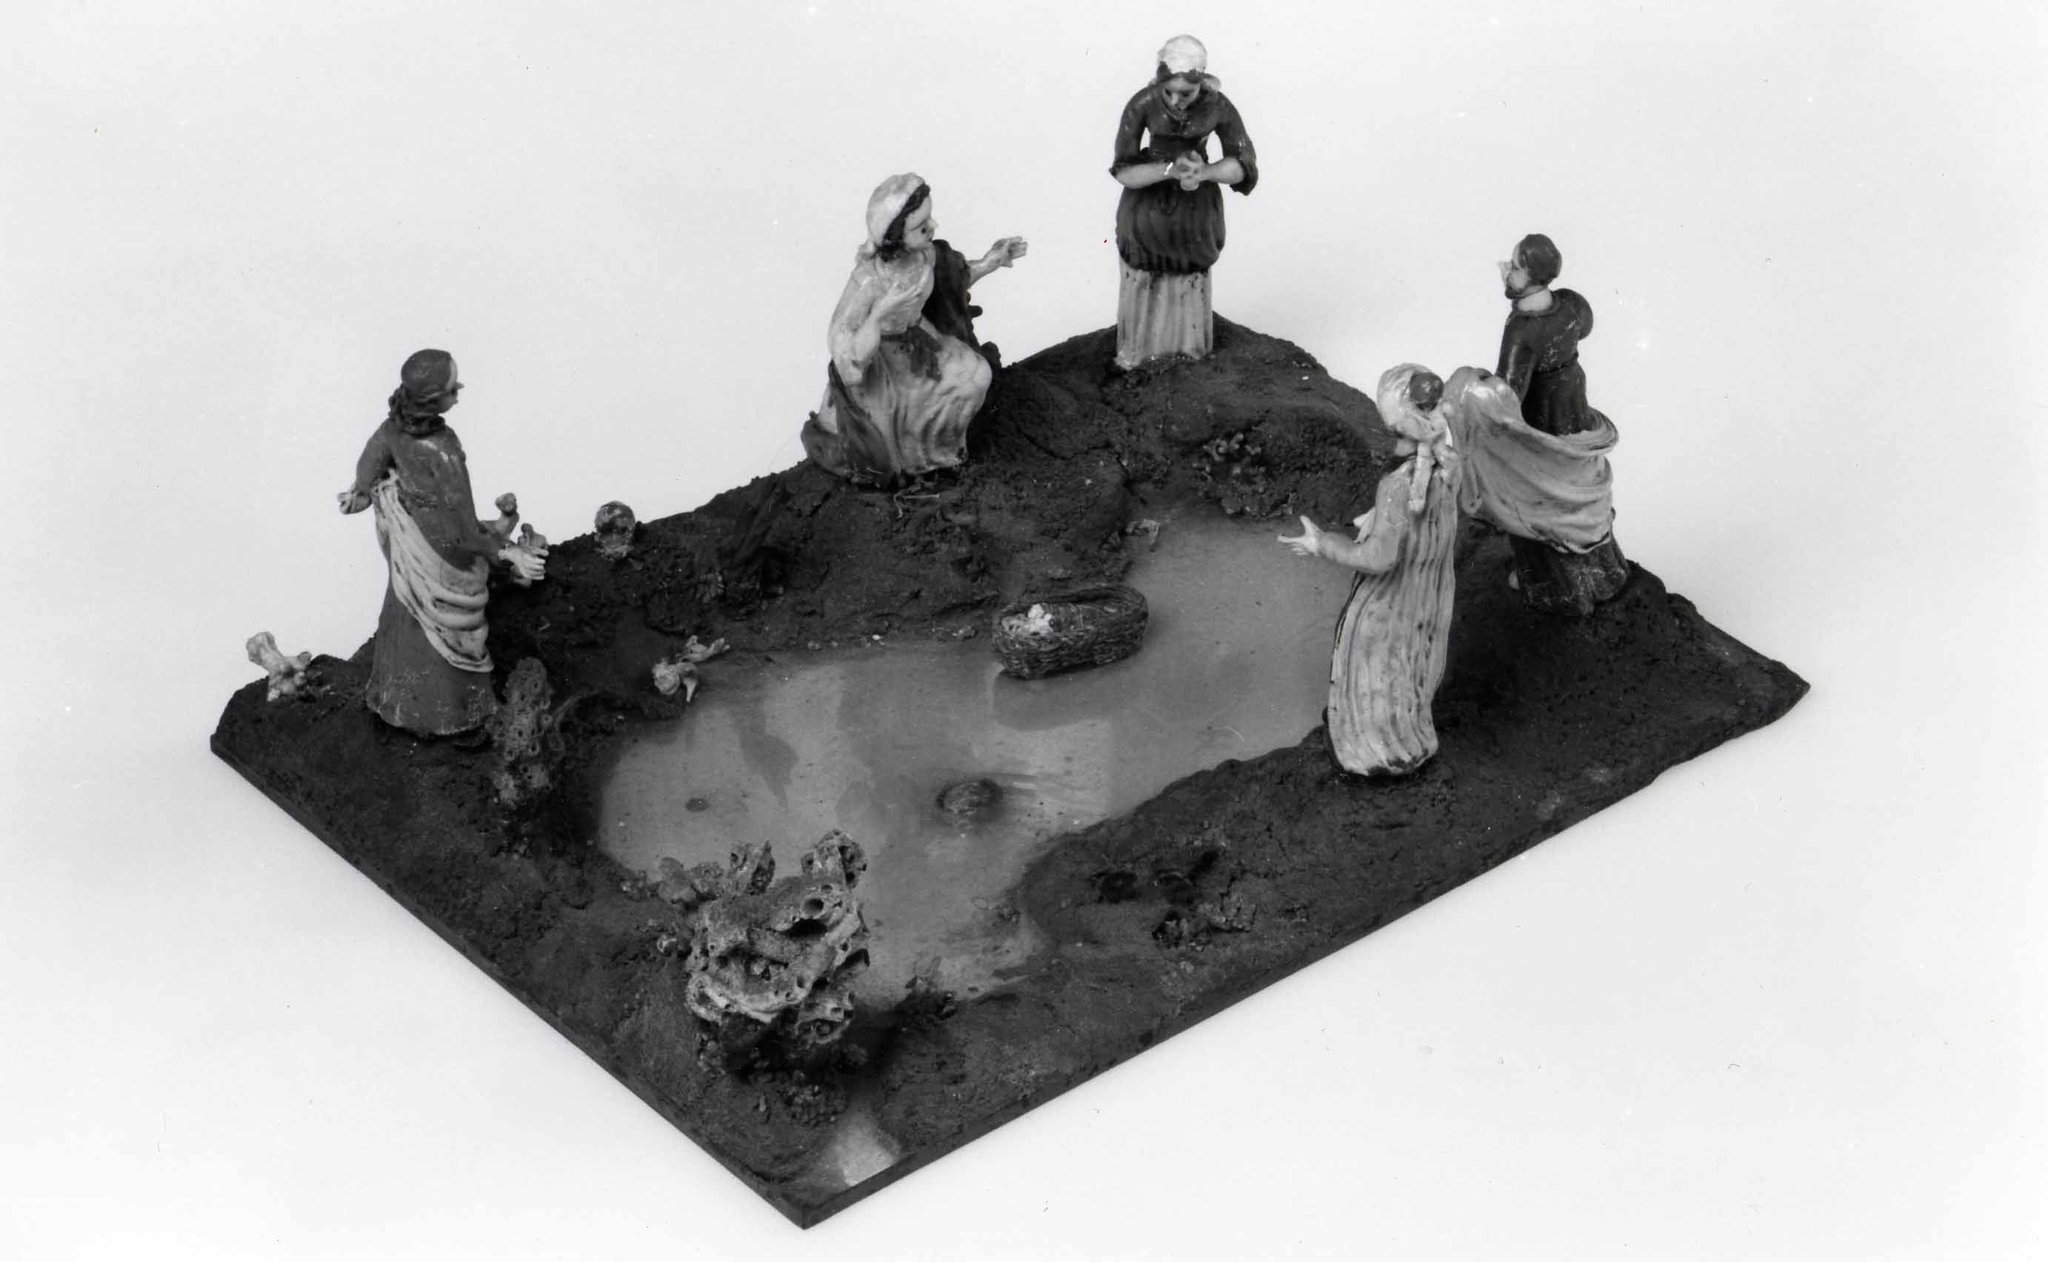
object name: figurine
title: The Finding of Moses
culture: french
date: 1701-1800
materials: coral, glass, metal, paint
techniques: lampwork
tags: infants,women,moses